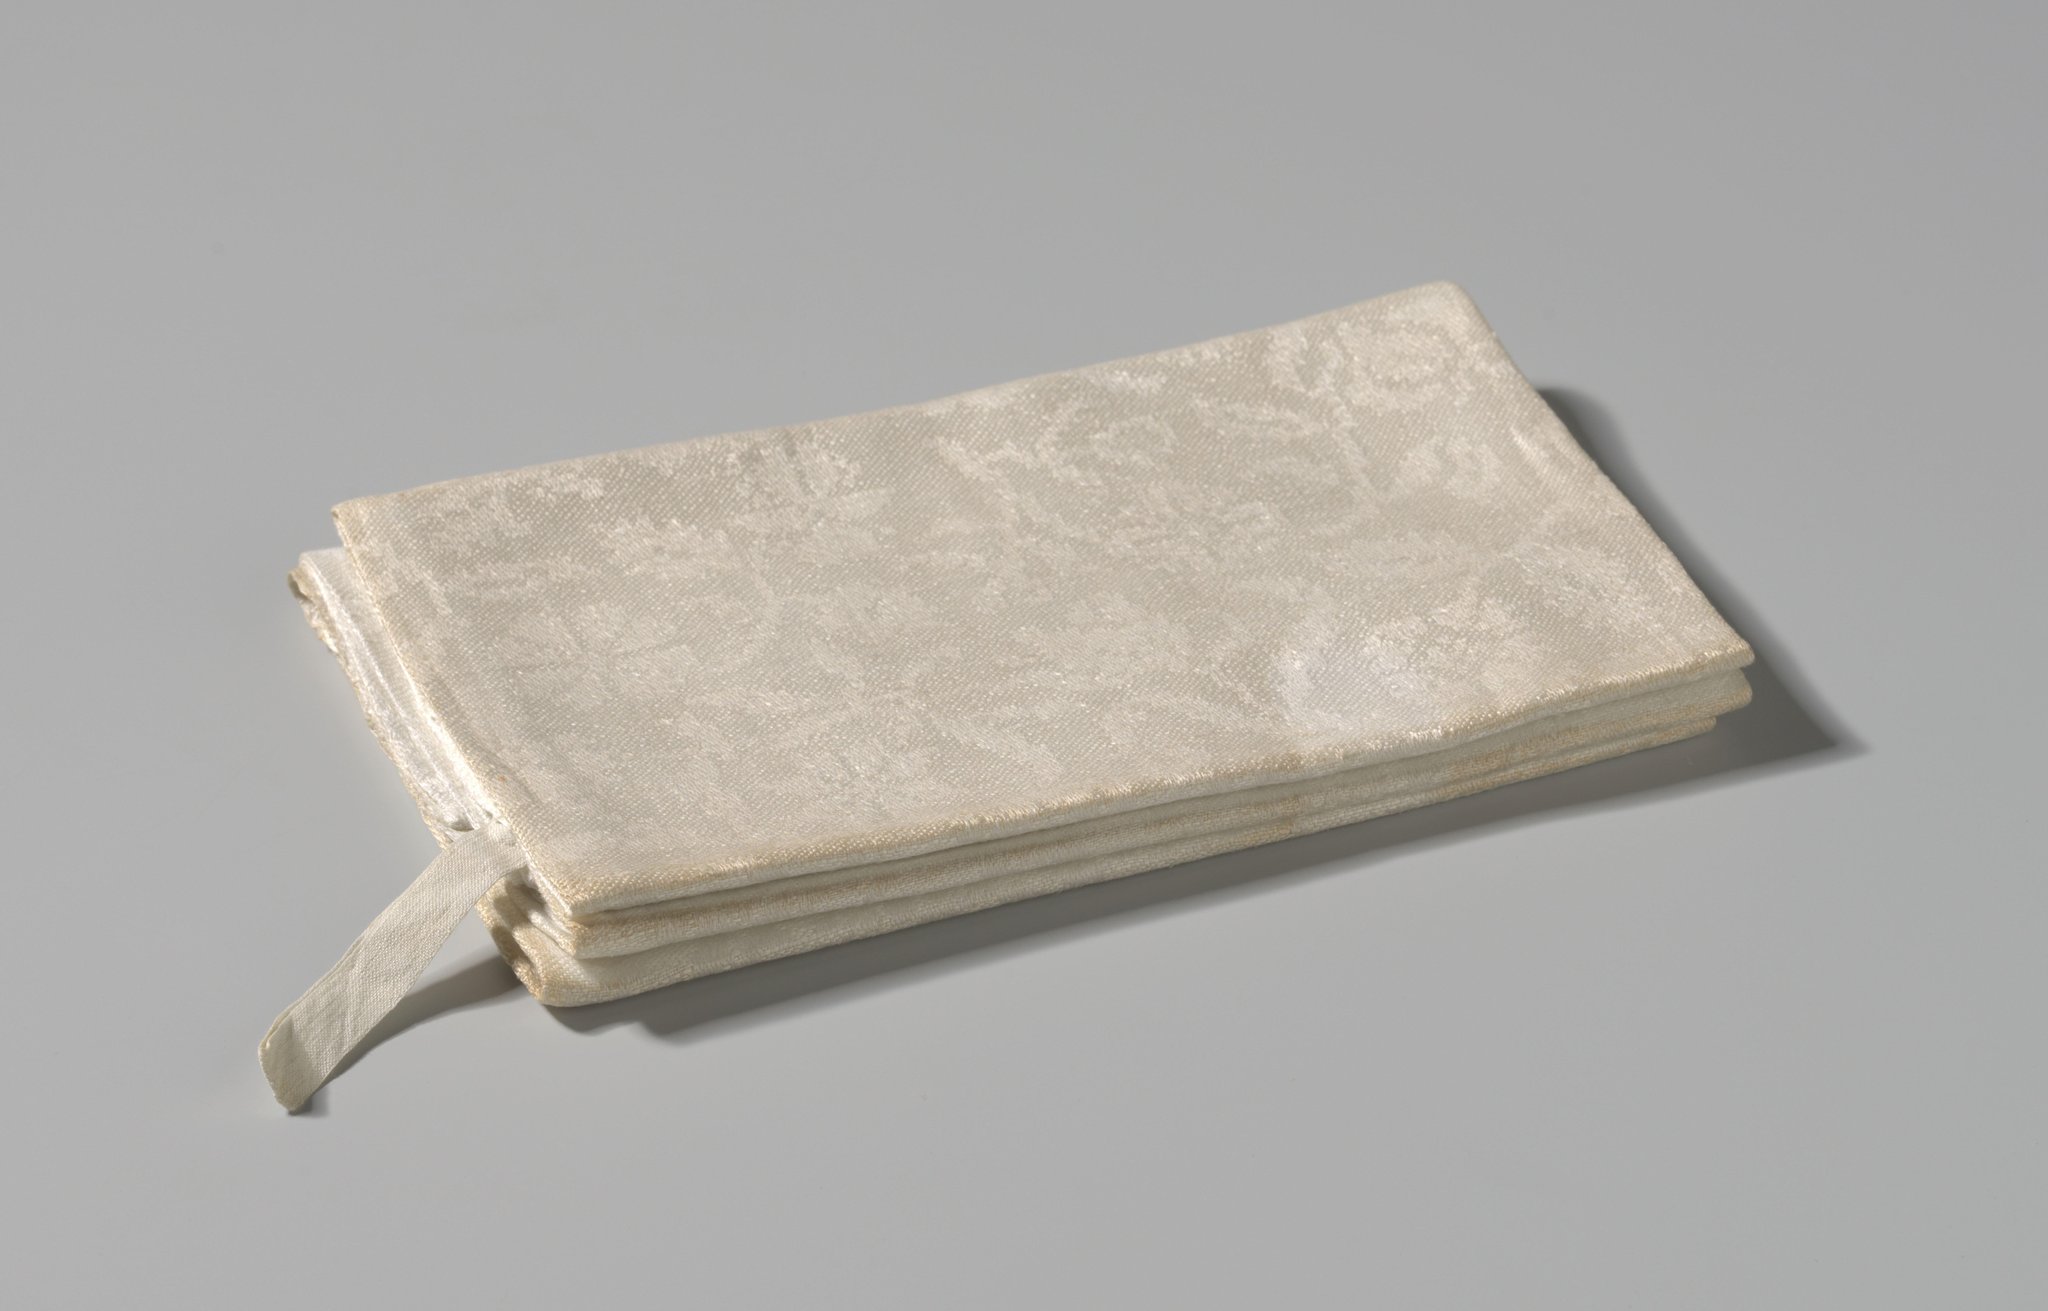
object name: fragment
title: Tafellaken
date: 1650-1665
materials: linen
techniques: damask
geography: northern netherlands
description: Wit linnendamasten tafellaken met patroon van gestrooide bloempjes, merk HW 6.